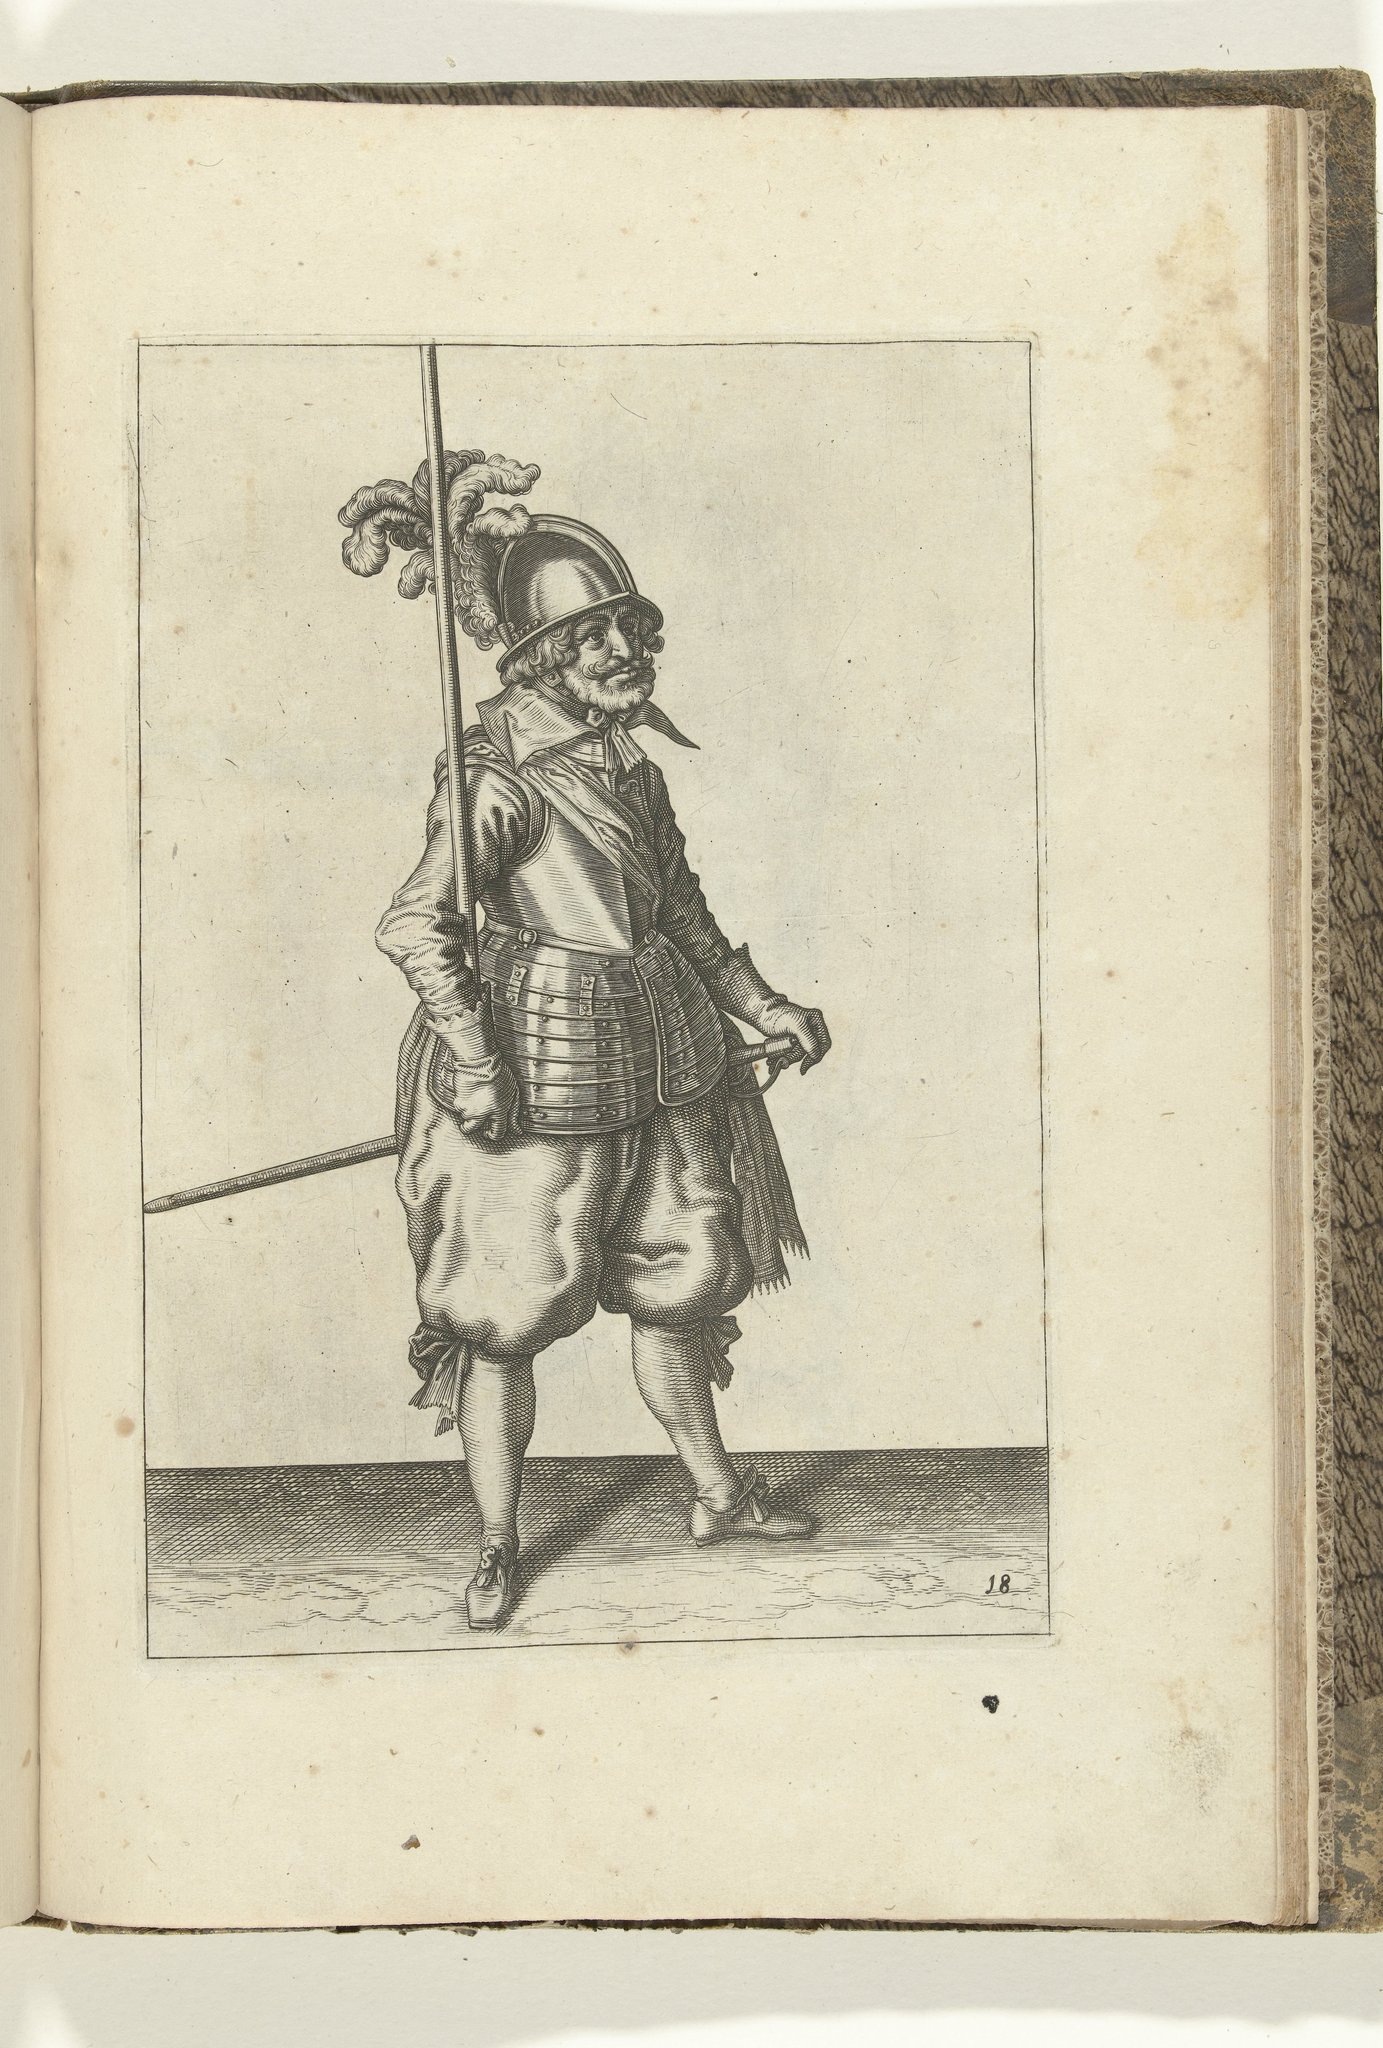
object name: print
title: Soldaat die zijn spies in de rechterhand verticaal draagt (nr. 18), ca. 1600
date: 1597-1608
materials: paper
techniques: engraving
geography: amsterdam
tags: the hague, maurice (prince of orange), handling of weapons ~ military training, weapons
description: Een soldaat, ten voeten uit, die een spies (lans) in zijn rechterhand geleund tegen zijn rechterarm verticaal vasthoudt (nr. 18), ca. 1600. Plaat 18 in de instructies voor het hanteren van de spies: Enseignement brief; et succint sur les portraitz figurez, touchant l'usage, de tout ce qu'un Soldat doibt faire au maniement de la Pique. Onderdeel van de illustraties in een Franse editie van J. de Gheyns Wapenhandelinghe: J. de Gheyn, Maniement d'armes, d'arquebuses, mousquetz et piques : en conformité de l'ordre de Mour le Prince Maurice, Prince d'Orange, Amsterdam 1608. Krijgswezen rond 1600.